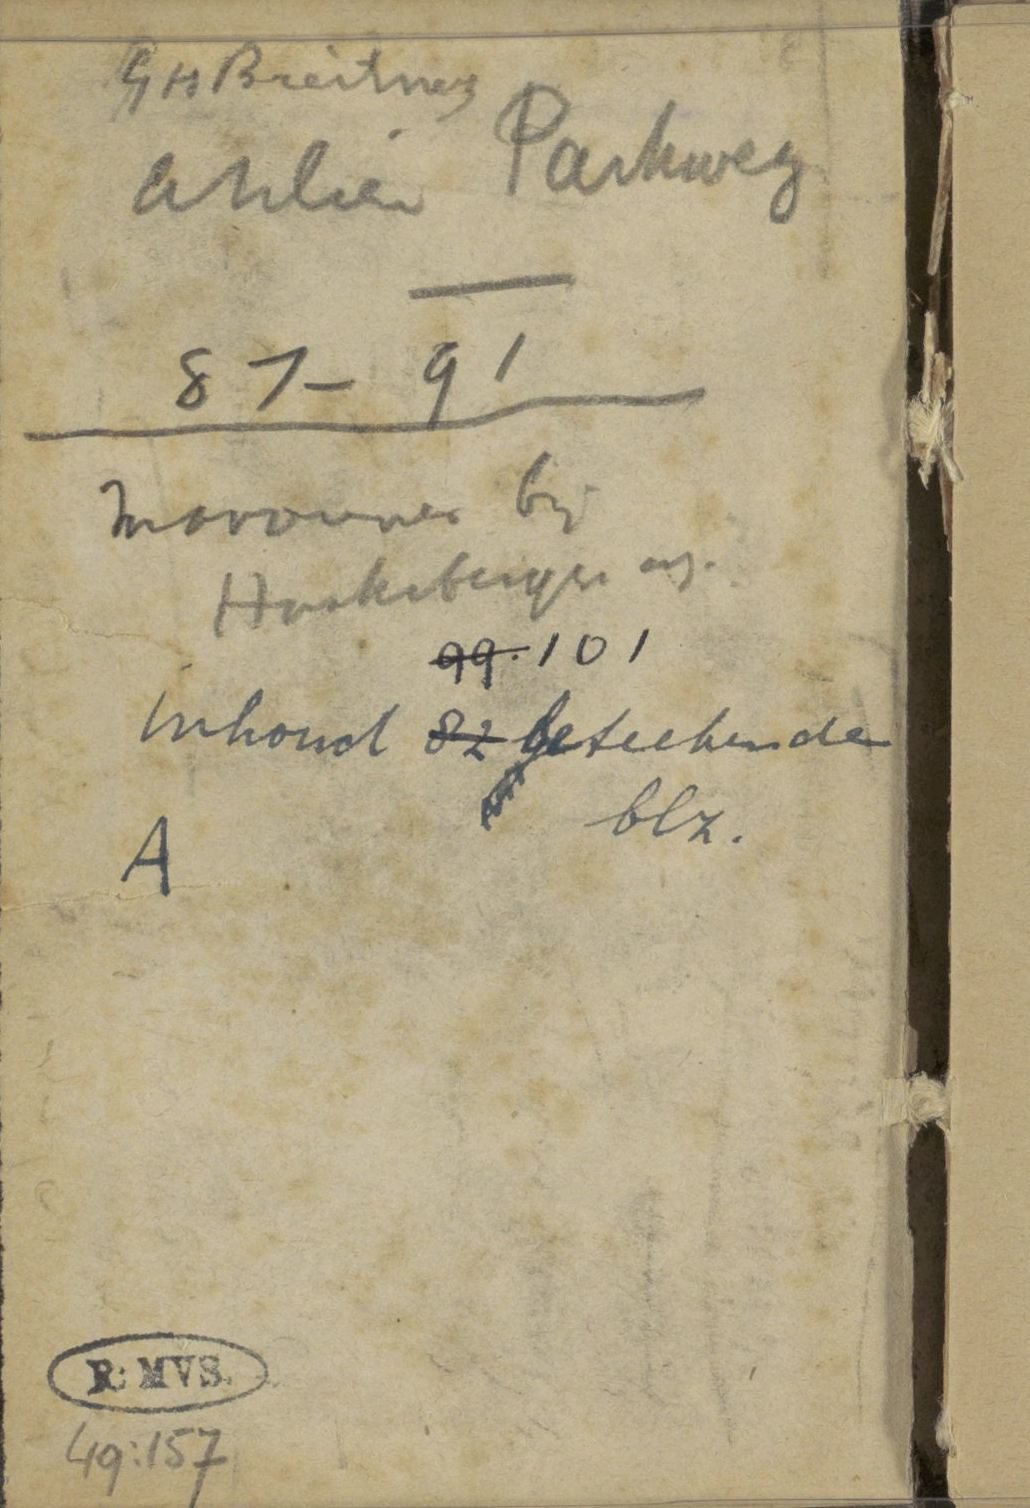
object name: sketchbook leaf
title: Annotaties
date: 1887-1891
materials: paper, pencil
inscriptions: annotation: ‘[...] Parkweg/ 87-91/ [...] bij/ Haaksbergen’, collector's mark: Lugt 2228, signature: ‘G H Breitner’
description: Pagina 1, voorste schutblad, uit een schetsboek met 83 bladen.